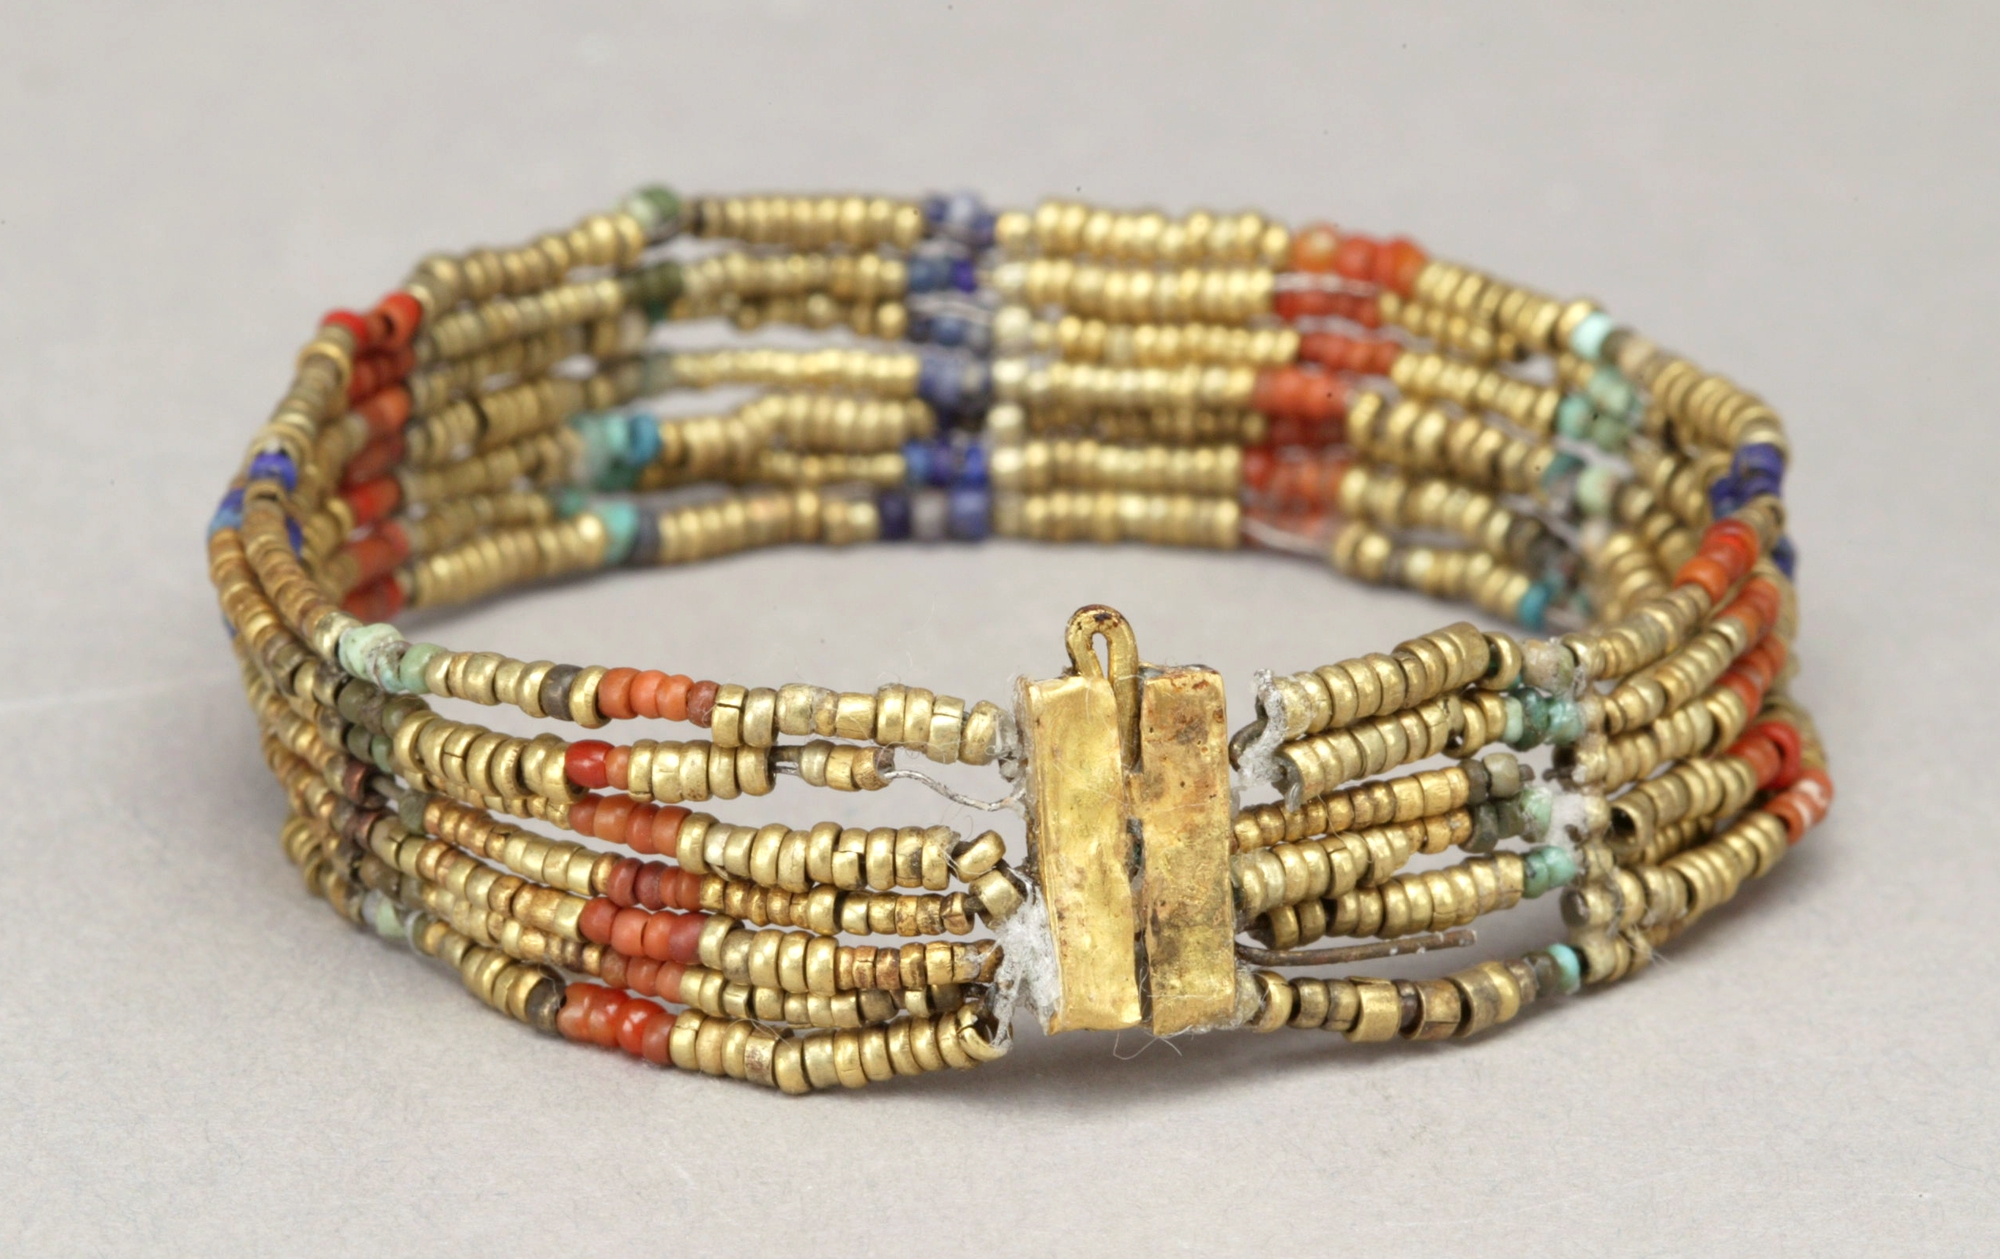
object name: armlet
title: Beaded Armlet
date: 1550-1525 BCE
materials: bronze, gemstone, copper, faience, glass, gold, lapis lazuli, metal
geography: egypt